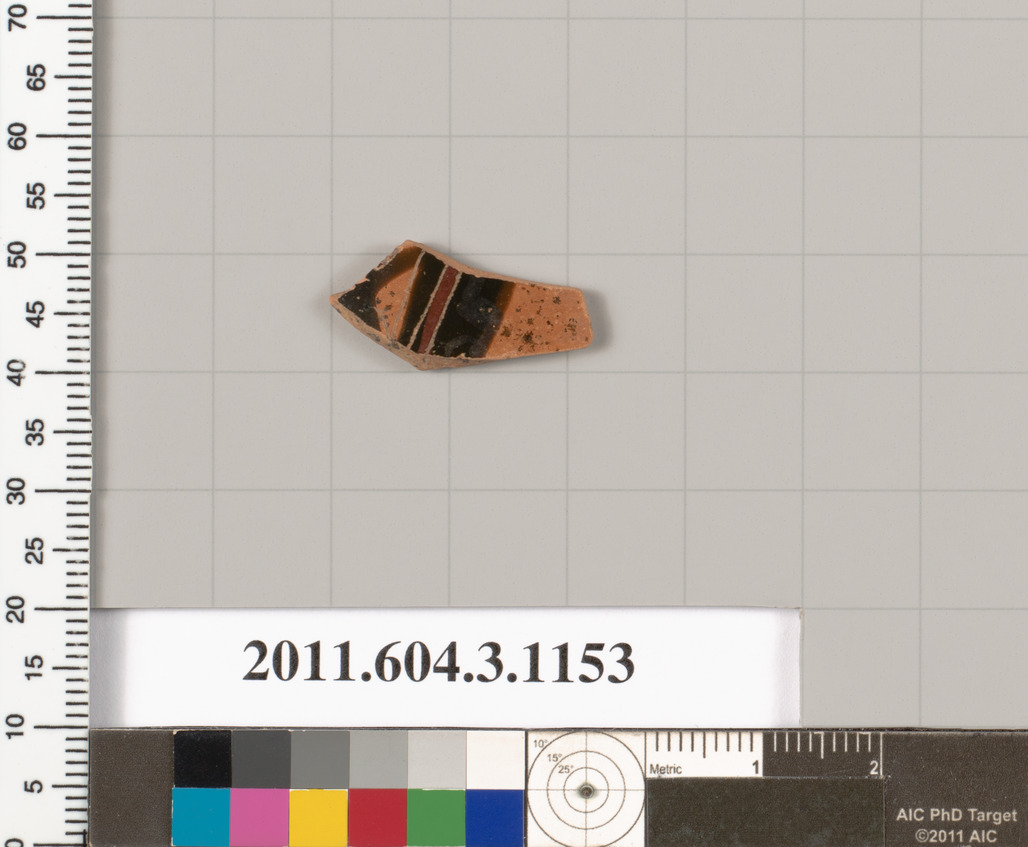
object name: mastoid or kyathos fragment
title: Terracotta fragment of a mastoid (drinking cup with narrow base) or a kyathos (cup-shaped ladle)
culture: greek, attic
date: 534-468 BCE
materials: terracotta